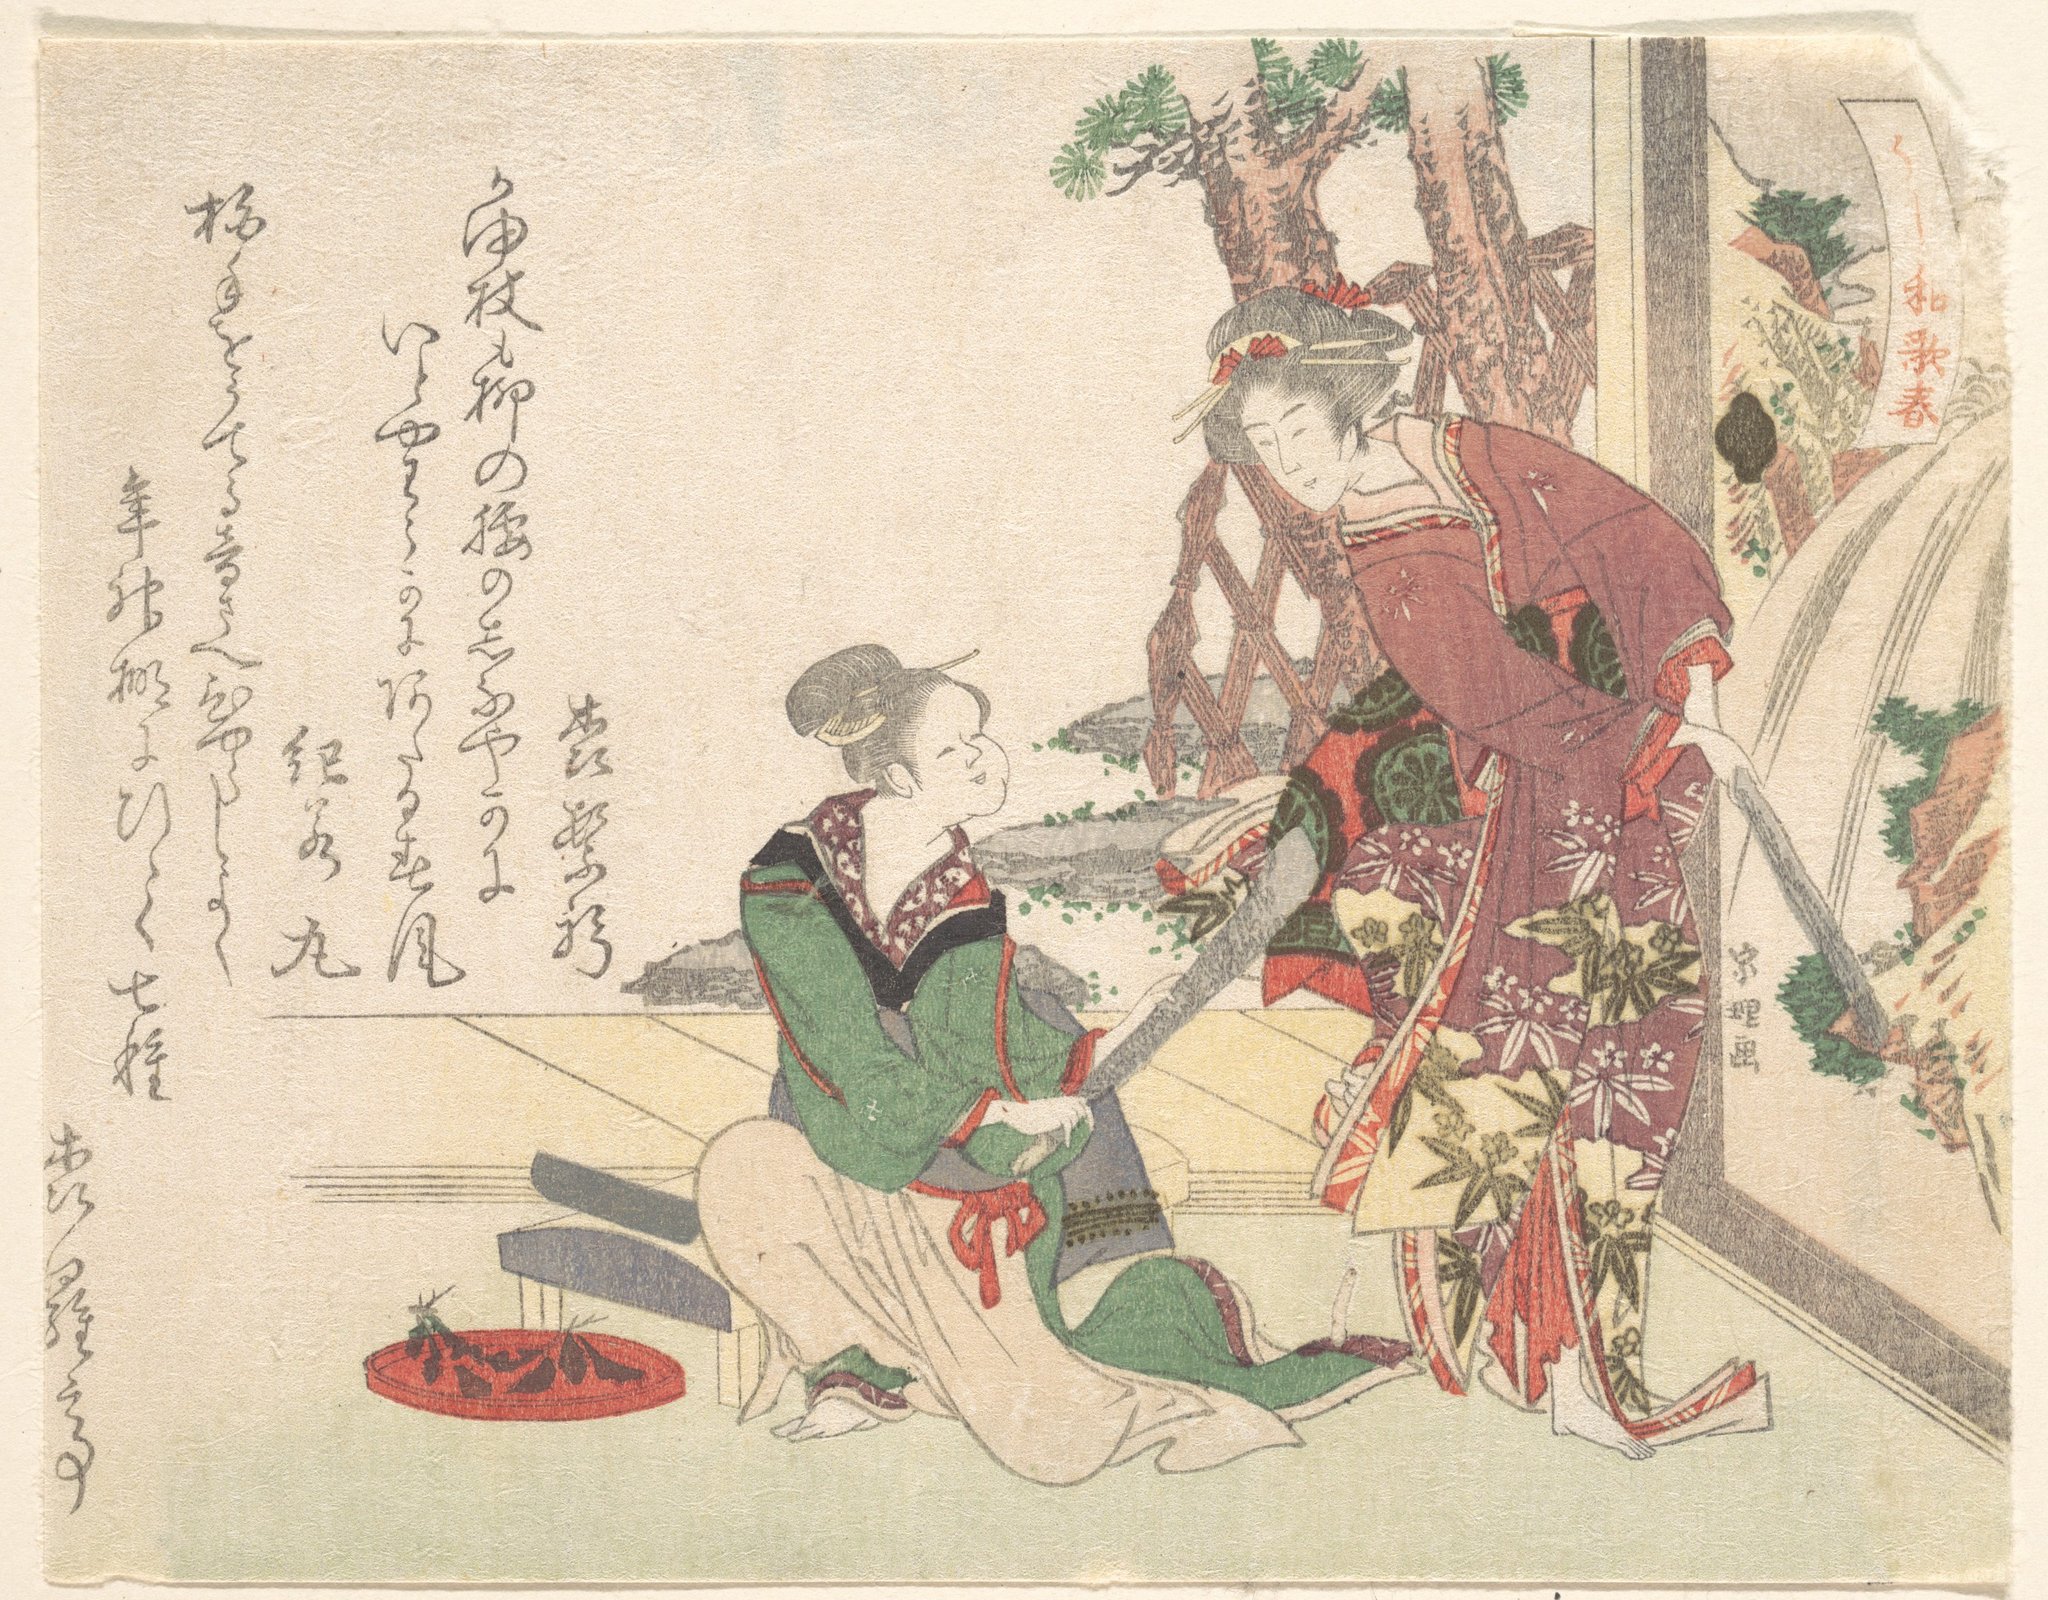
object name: print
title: Two Women, from the series Spring Poems on Ushiwaka for the Year of the Ox (Ushiwaka haru)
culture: japanese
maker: hishikawa sōri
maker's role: artist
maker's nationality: japanese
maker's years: 1797-1813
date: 1805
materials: ink, paper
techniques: surimono, woodblock print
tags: women,trees